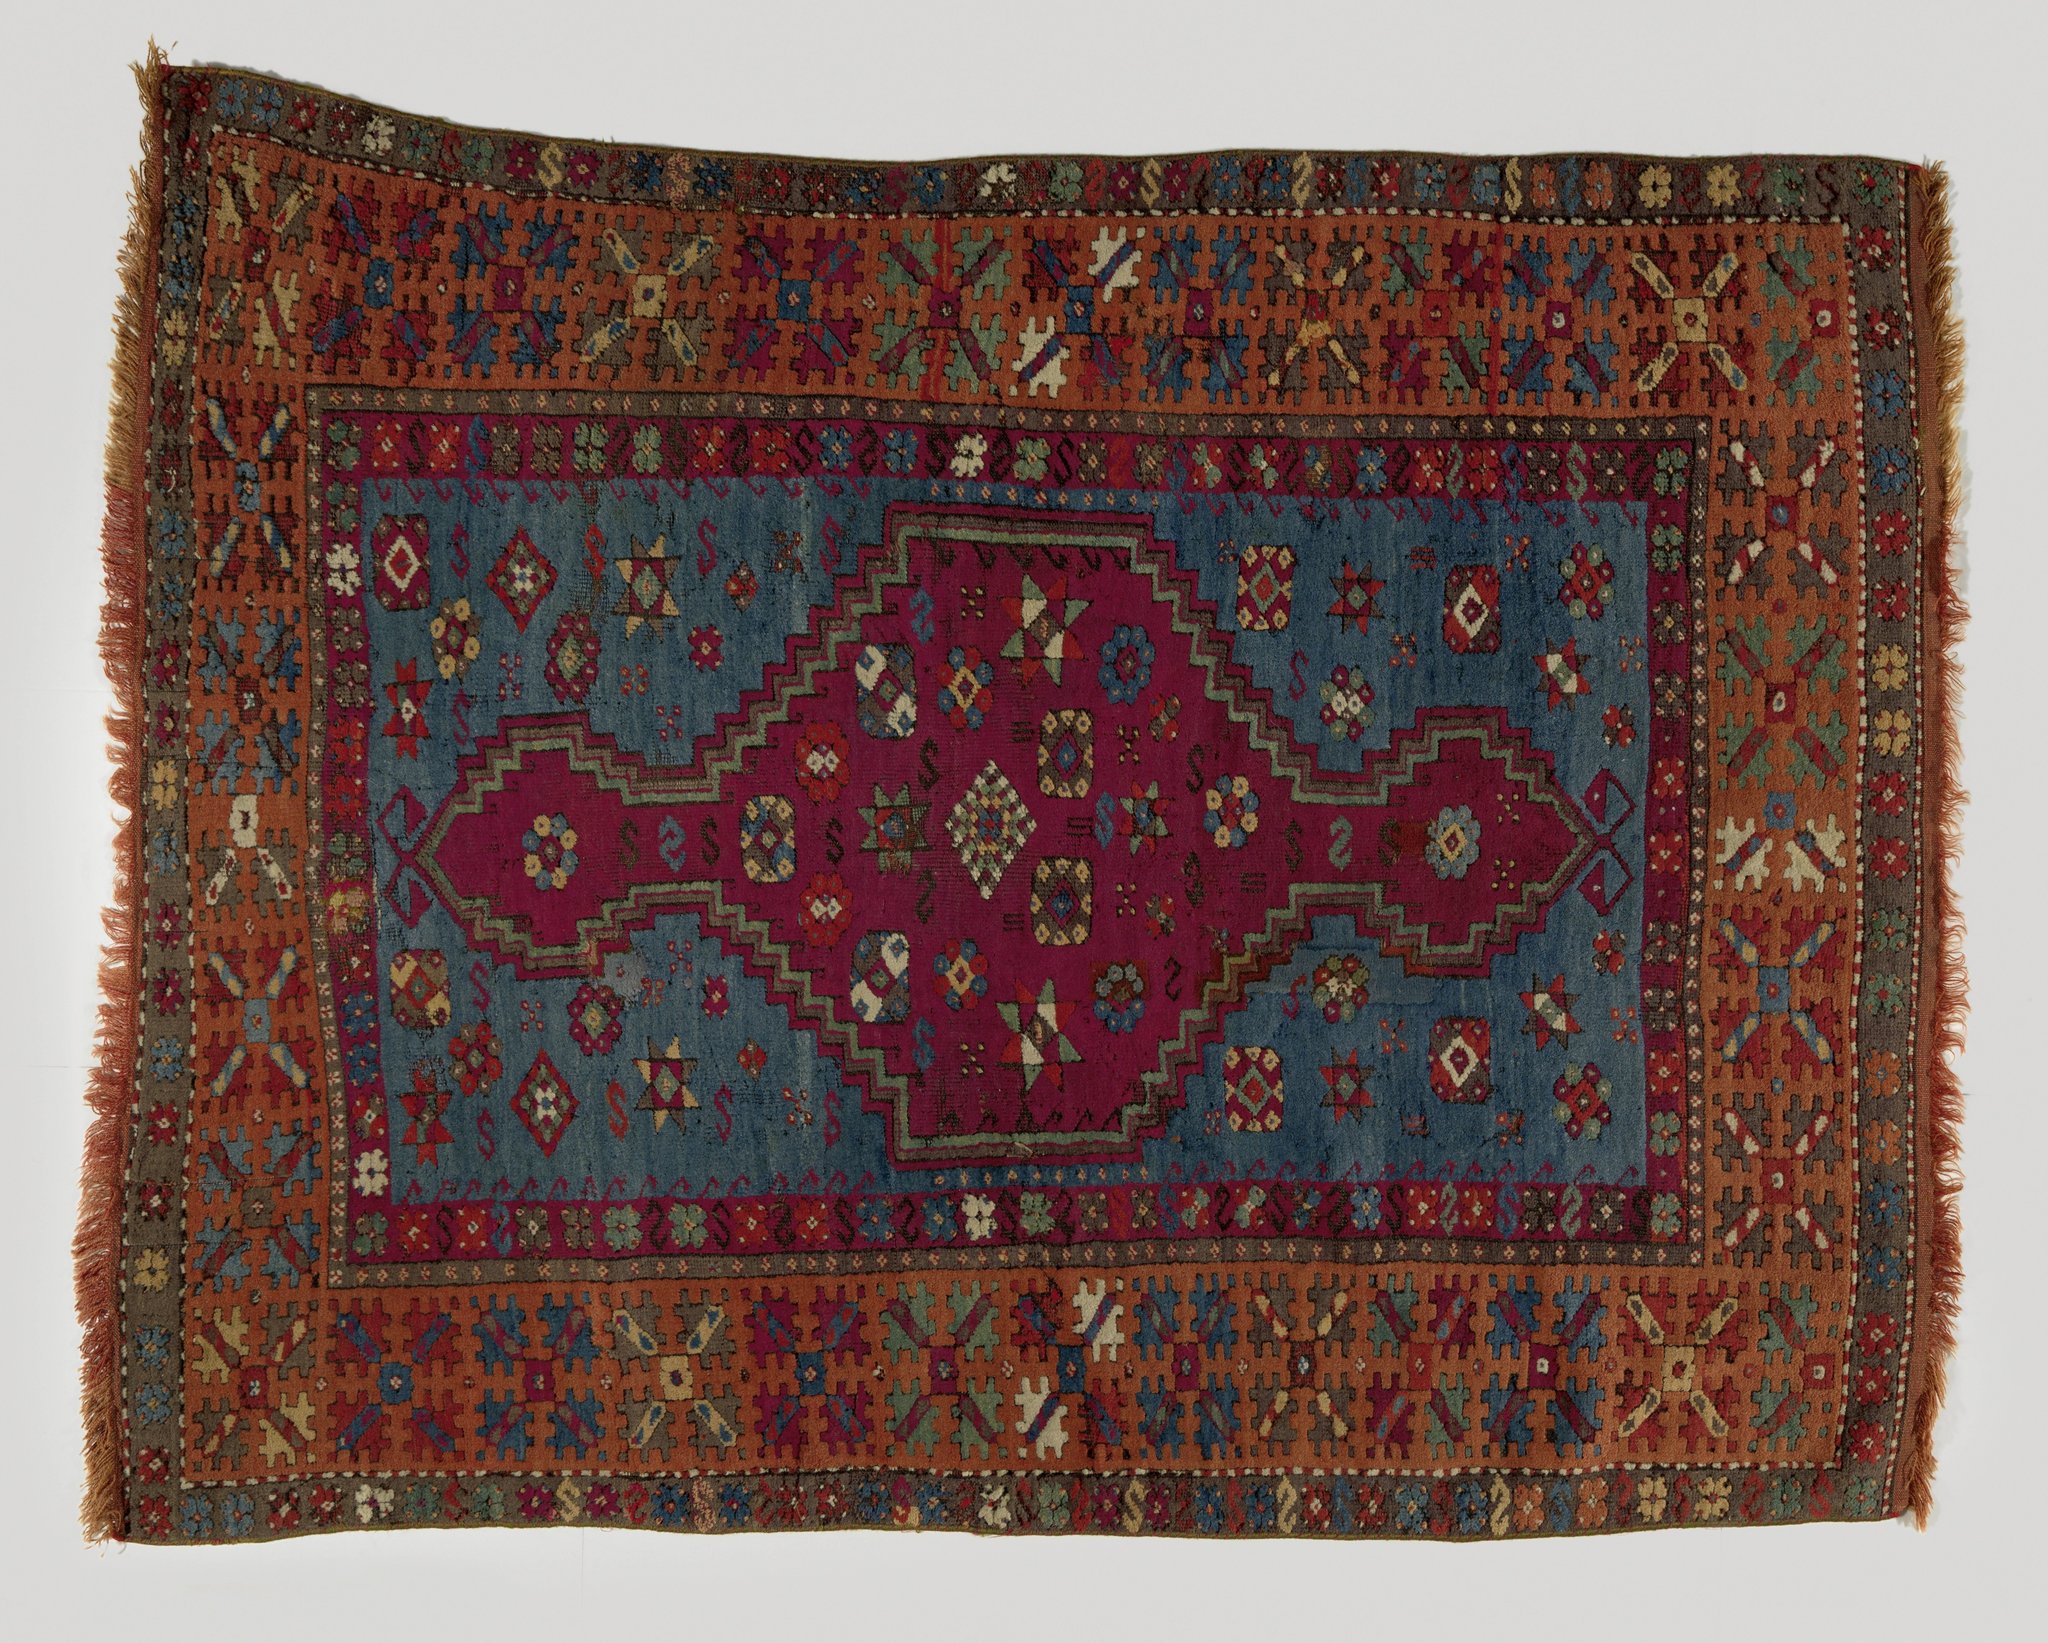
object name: medaillonkleed, medaillontapijt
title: Medaillonkleed, YURUK of "SULTAN"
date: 1850-1900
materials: wool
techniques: ghiordes knot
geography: yürük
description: Medaillonkleed, Yuruk of "Sultan". Middenveld: ijsblauw met groot kardinaalspaars medaillon met uitstulpingen onder- en bovenaan; beide laatste gevuld met strooigoed. Rand: drievoudig. De middelste hardoranje met vierdelige bloemen in bruin/beige, rood, blauw, paars, groen en wit. De binnenzoom is paars, de buitenzoom lichtbruin met gelijke bloemen.